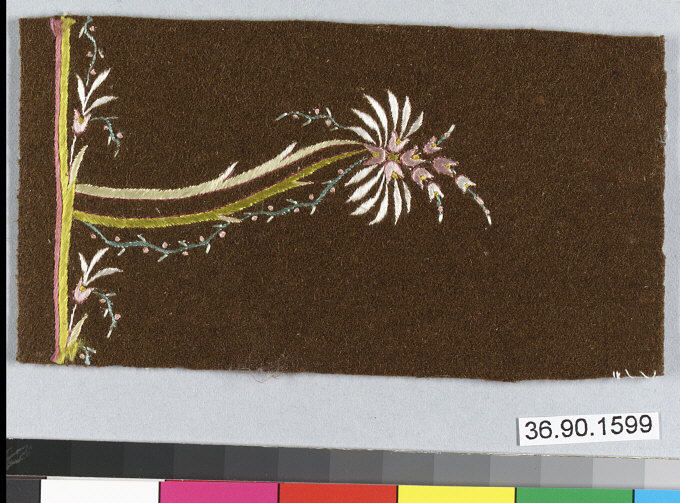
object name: sample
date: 1801-1833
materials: felt, silk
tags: flowers